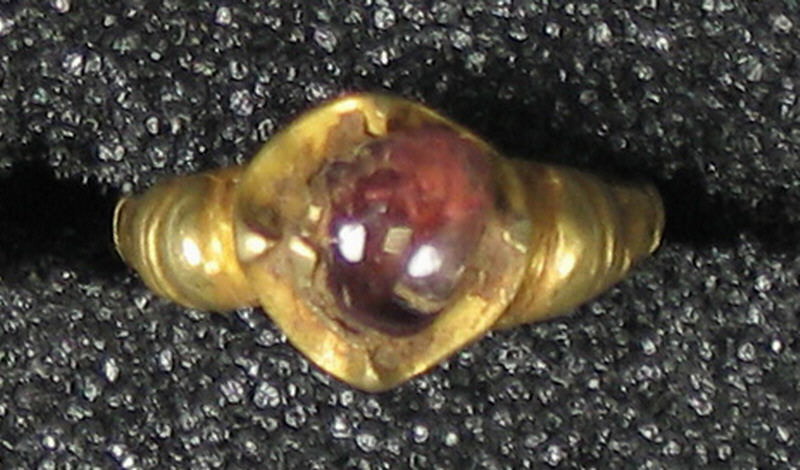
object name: ring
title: Ring with Red Stone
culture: indonesian, central java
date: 701-1200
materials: gold, stone